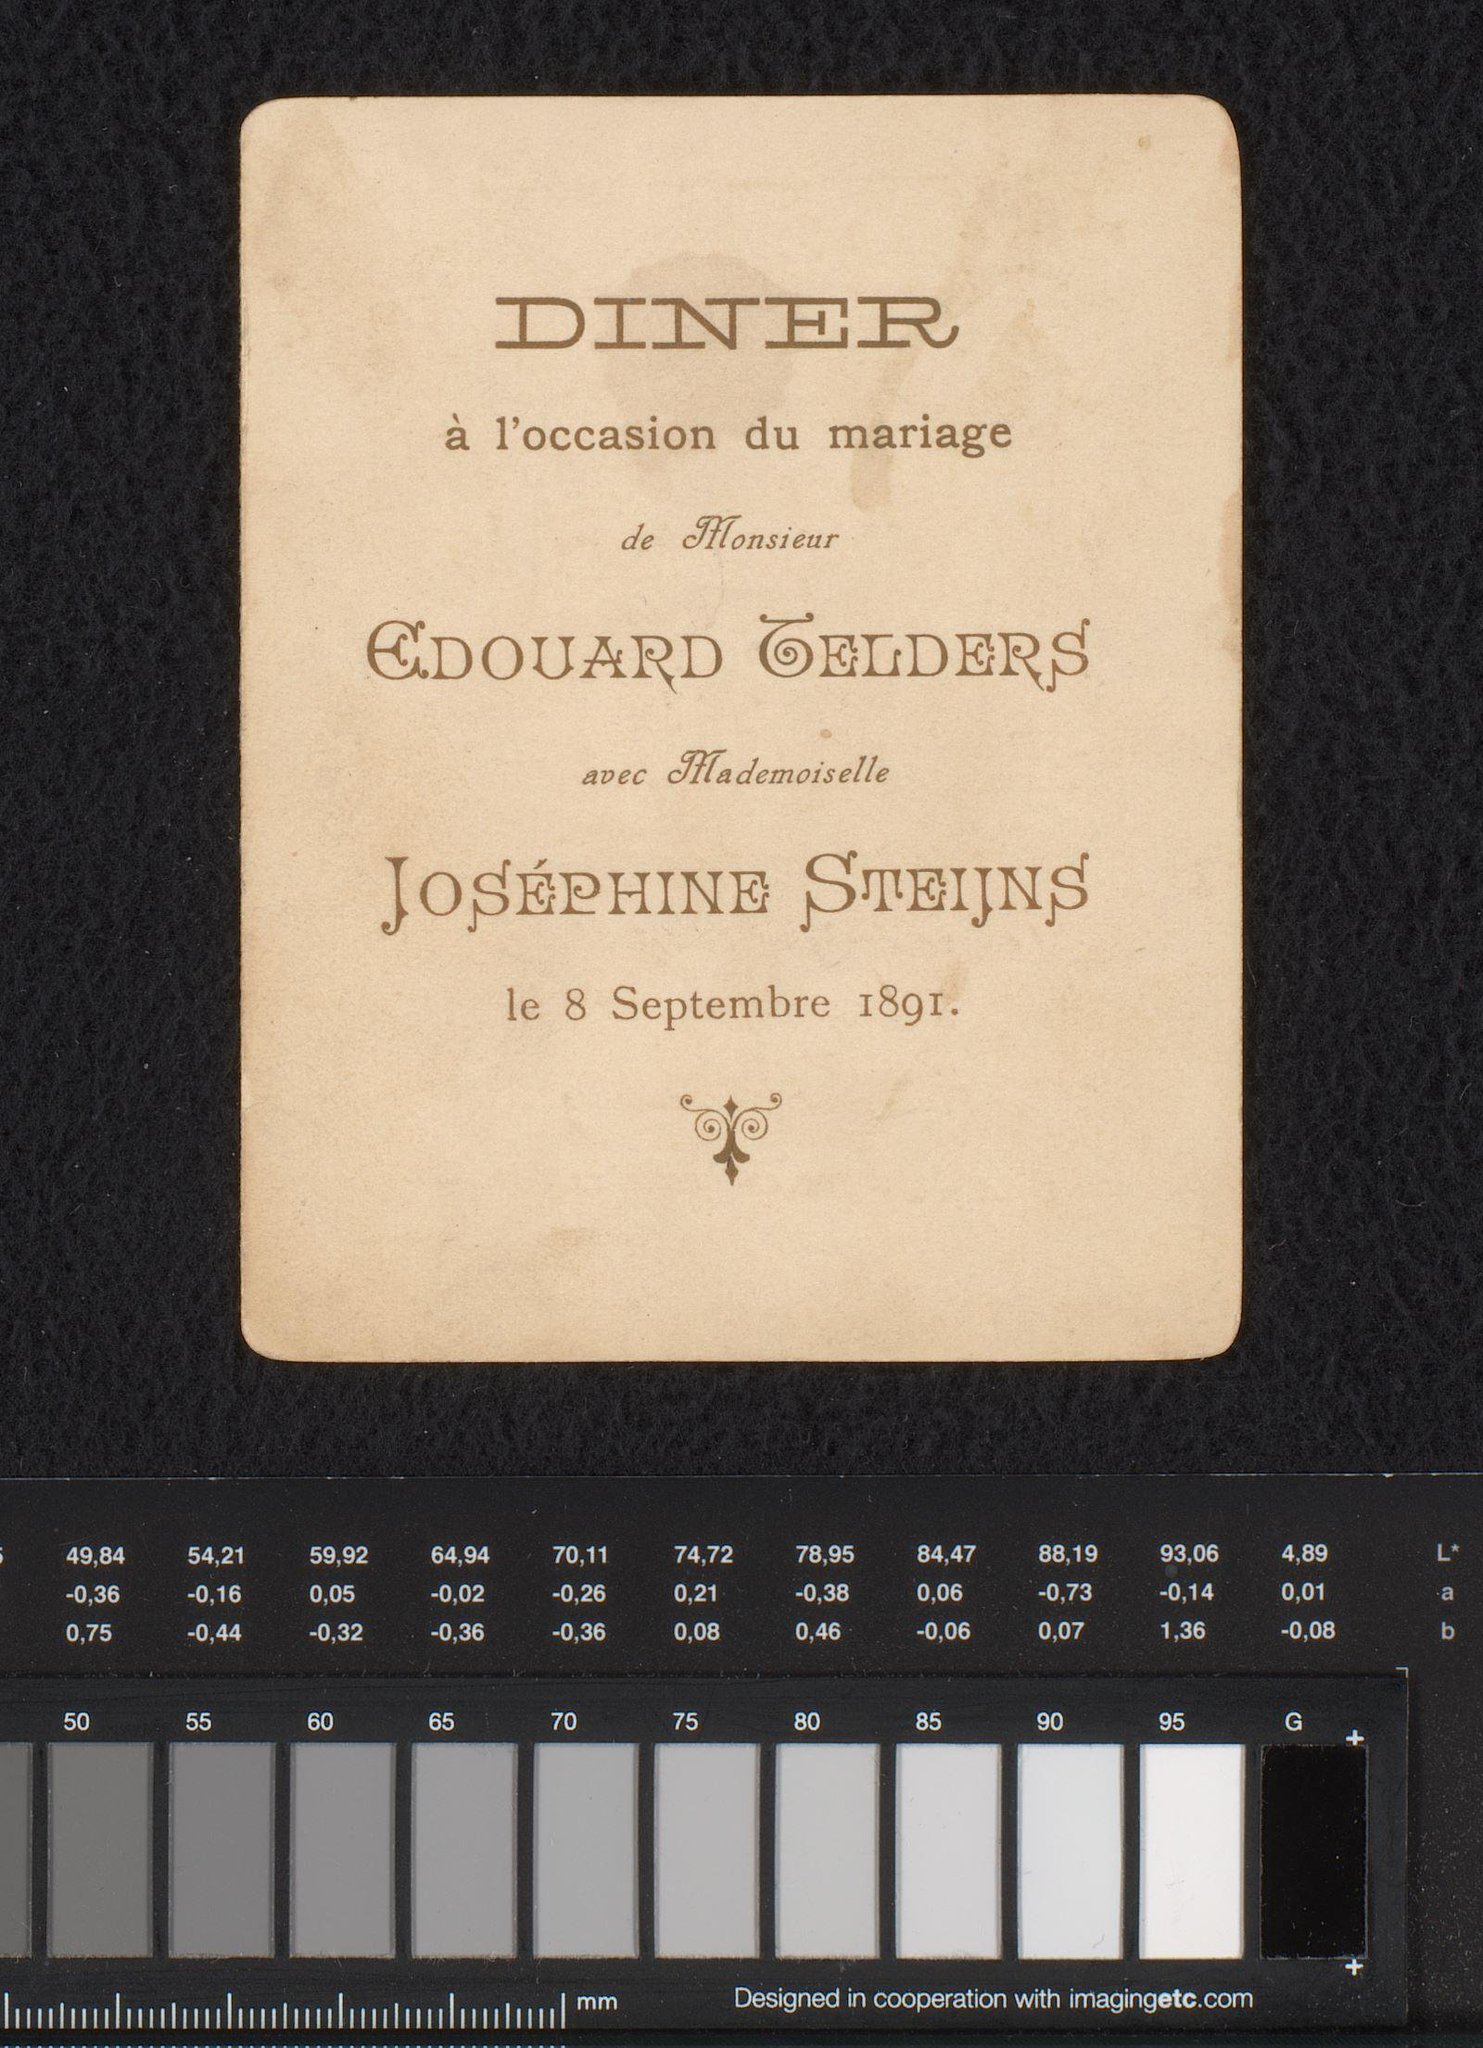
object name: photomechanical print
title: Menu van het diner ter ere van het huwelijk van Edouard Telders en Josephina Steyns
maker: Anonymous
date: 1891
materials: paper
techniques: printing block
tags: maastricht, wedding feast, wedding meal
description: Typografische kaart met op de voorzijde details over het huwelijk dat op 8 september 1891 plaats zou vinden. Op de achterzijde het menu van het diner.